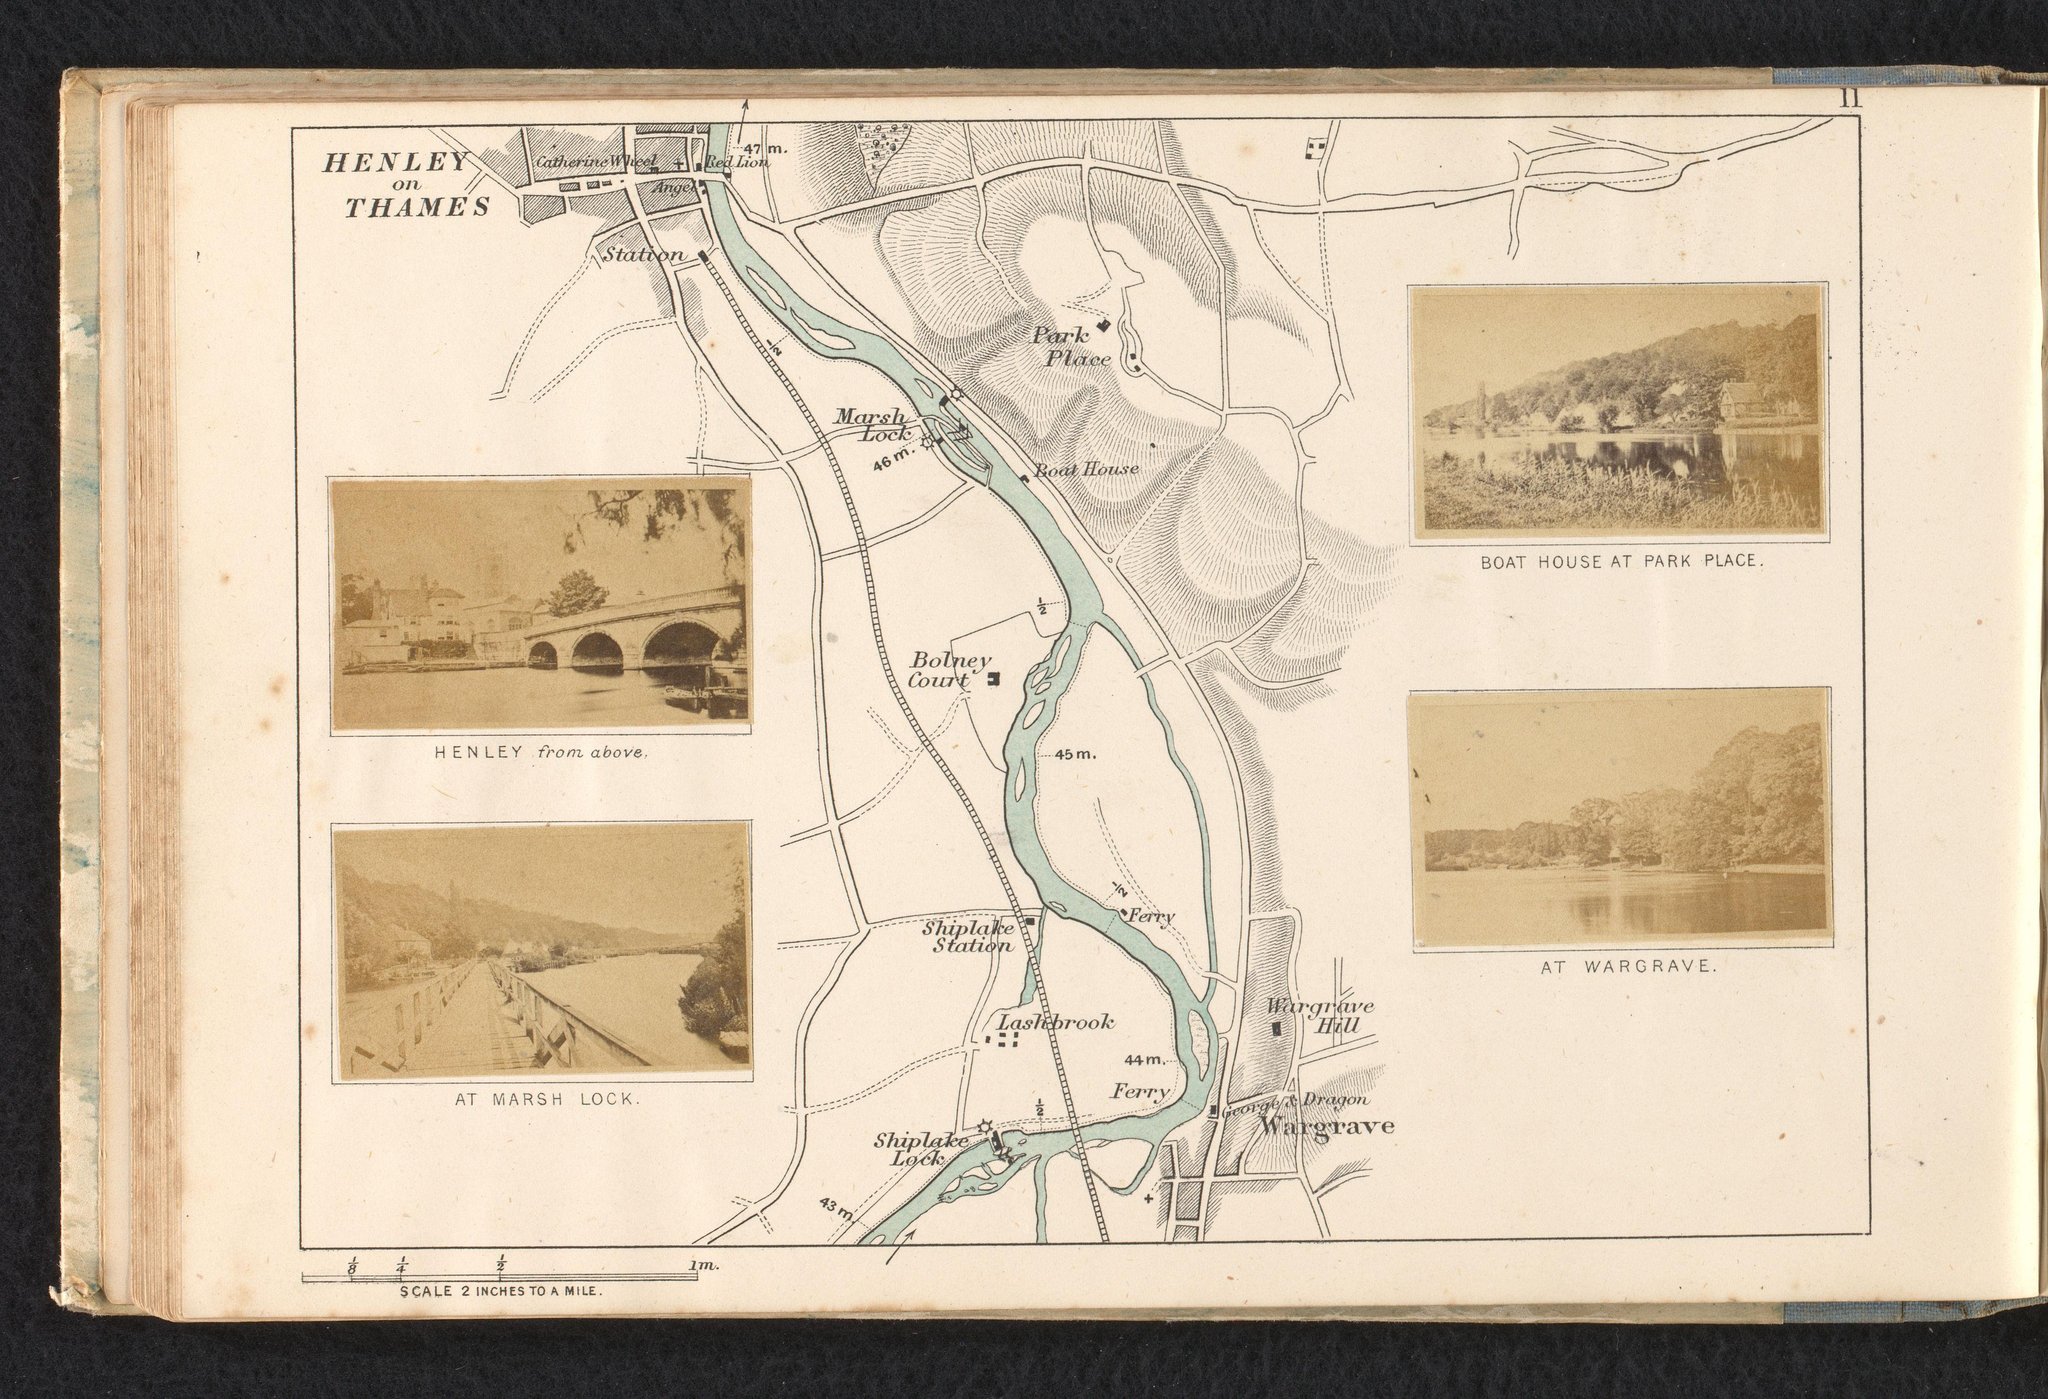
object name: photograph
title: Gezicht op landschap met botenhuis bij Park Place, gezicht op Henley-on-Thames met brug, gezicht op rivierlandschap bij Wargrave en schutsluis bij Henley-on-Thames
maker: Anonymous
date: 1868-1873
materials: paper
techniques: albumen print, letterpress printing, line block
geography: england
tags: landscapes in the temperate zone, river bank, landscape with bridge, viaduct or aqueduct, boat-house, shed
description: Foto's op vierde ongenummerde pagina na pagina 20.